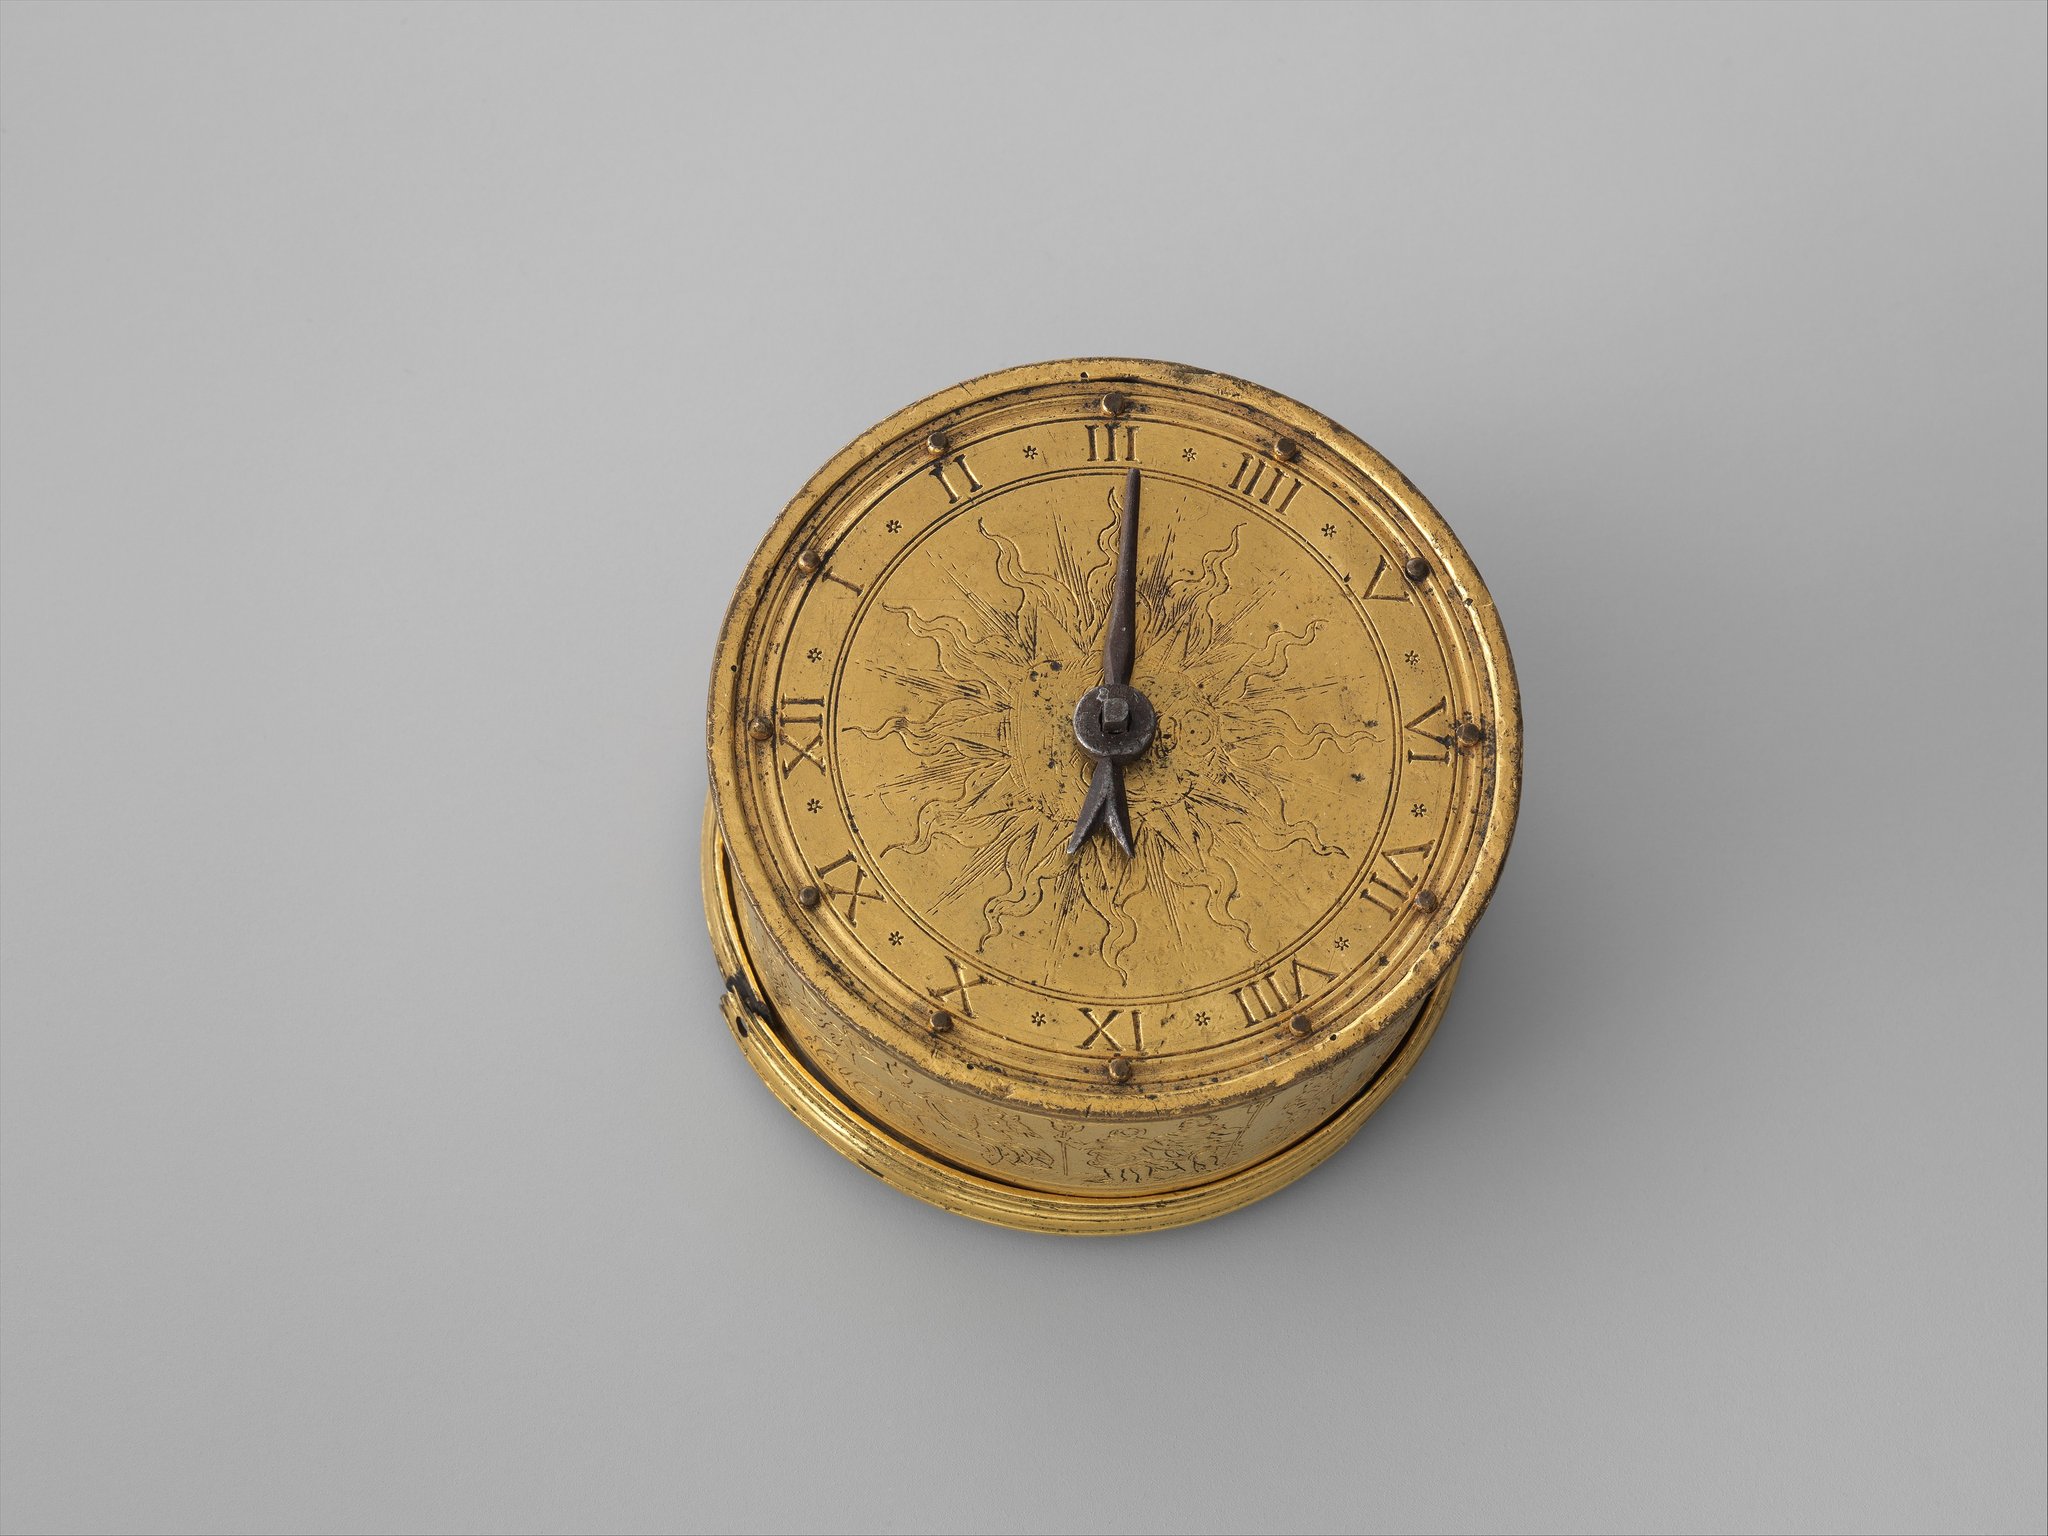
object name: table clock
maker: caspar behaim (chasparus bohemus)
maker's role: maker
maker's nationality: austrian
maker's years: 1568-1584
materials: brass, gilt, iron